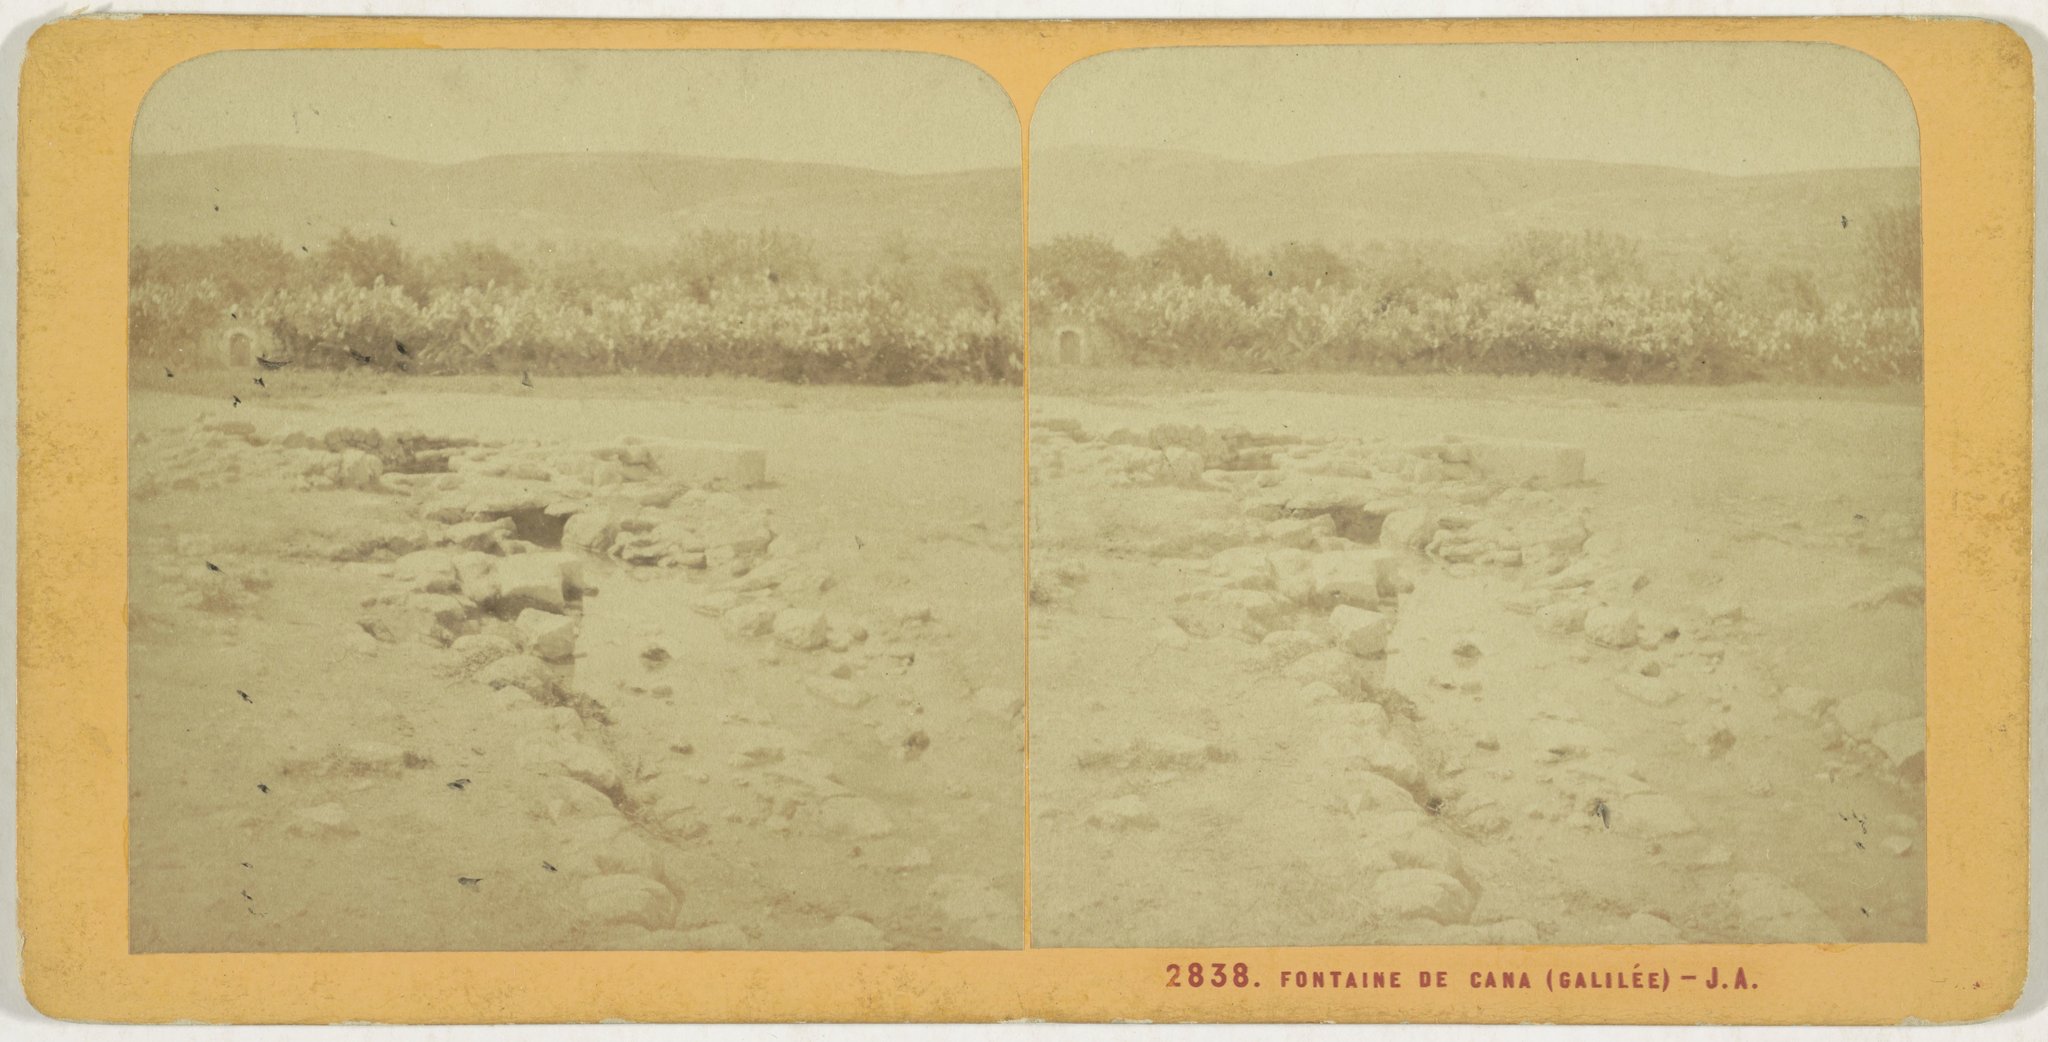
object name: stereograph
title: Gezicht op een water bij Cana, Israël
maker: jean andrieu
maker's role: fotograaf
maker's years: 1816-1872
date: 1862-1876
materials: cardboard, paper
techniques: albumen print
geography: cana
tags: water course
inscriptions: number: ‘2838.’